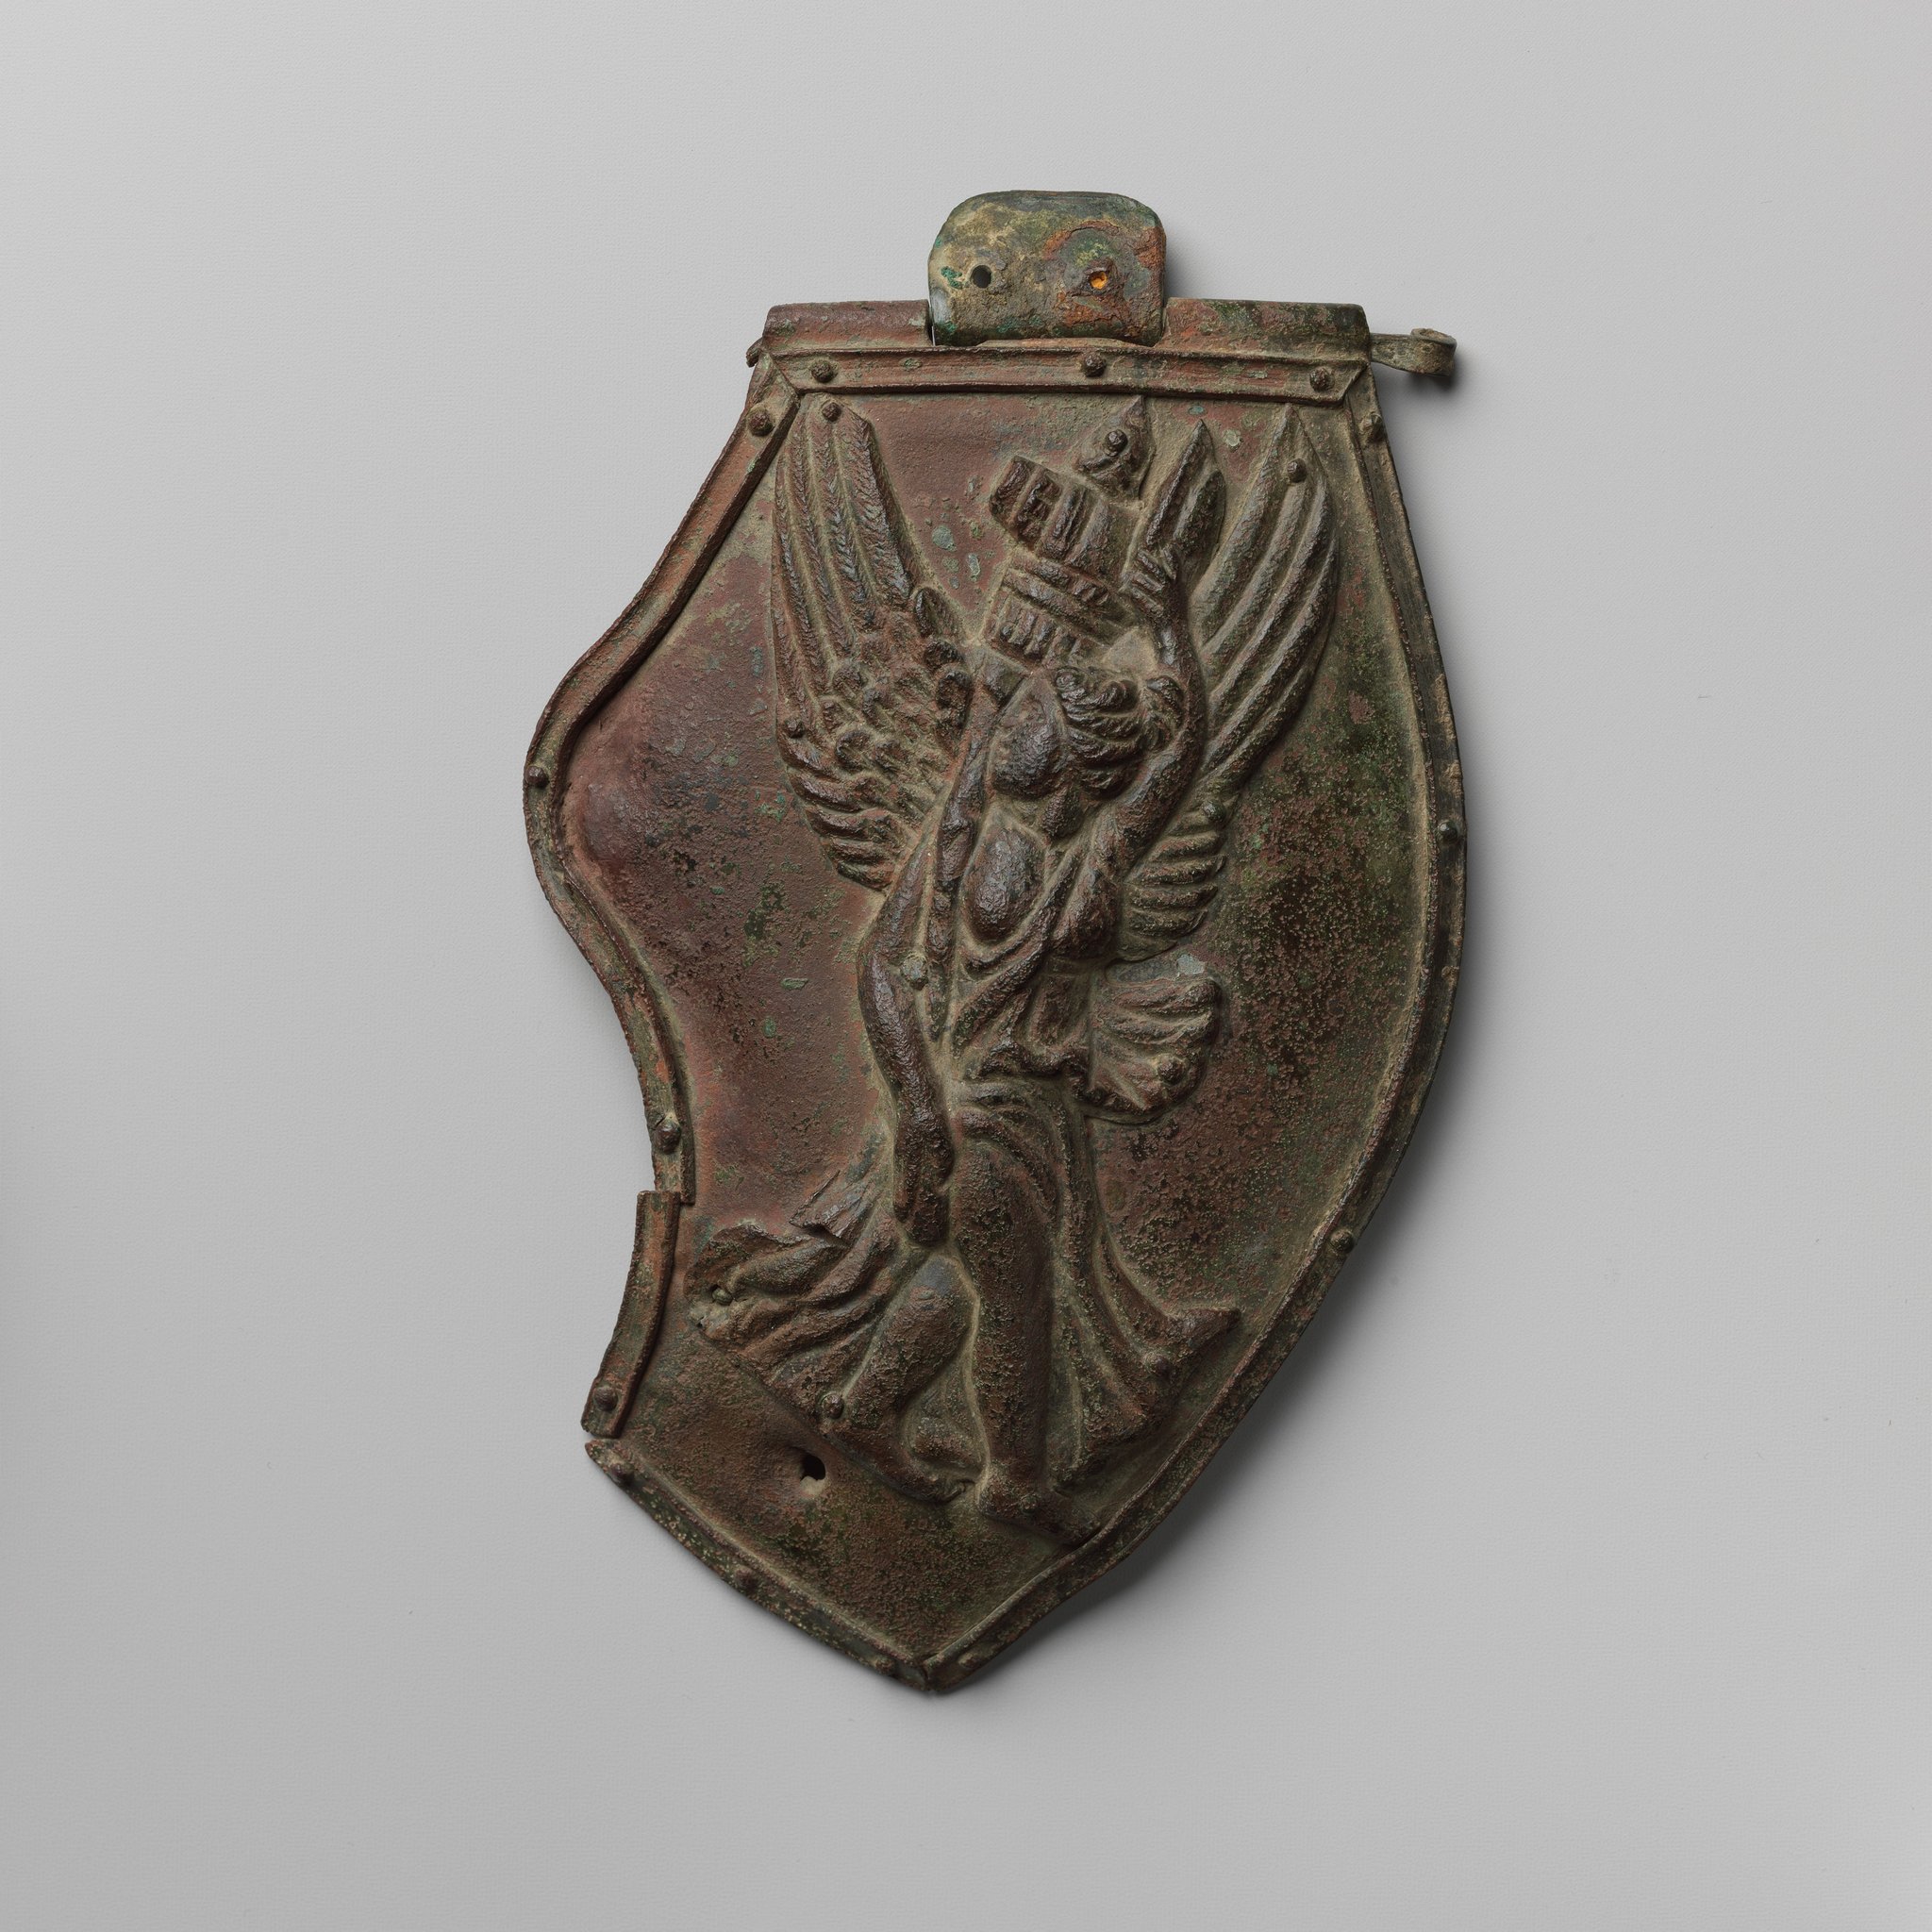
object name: helmet cheek piece of an officer's helmet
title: Bronze cheek piece of a helmet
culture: roman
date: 167-200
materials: bronze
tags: victory,trophies